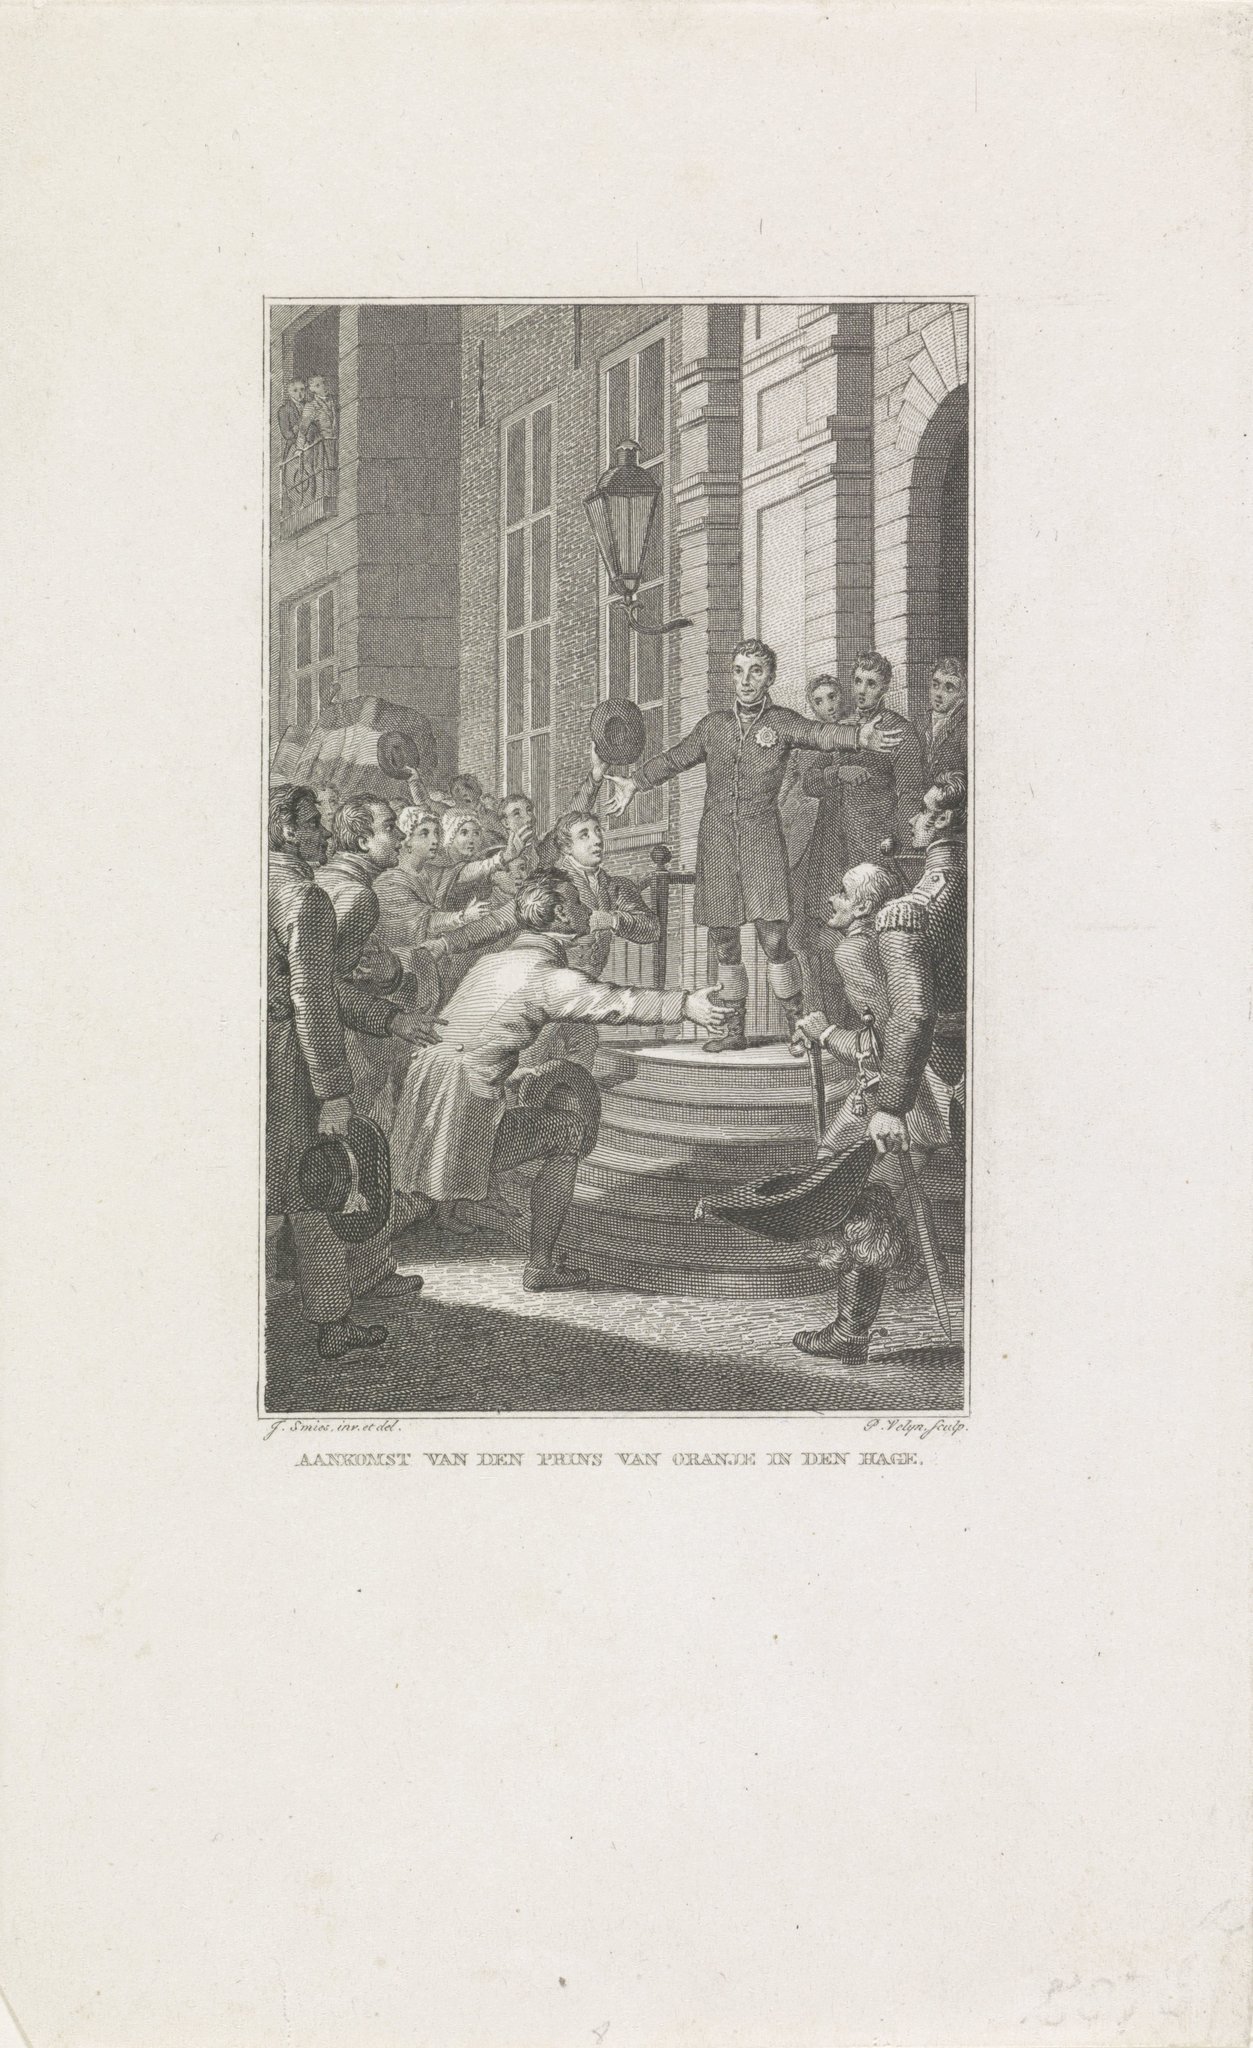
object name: history print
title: Aankomst van den prins van Oranje in Den Hage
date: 1823-1829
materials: paper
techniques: etching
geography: netherlands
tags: the hague, berlin, william i of the netherlands, being welcomed ~ travelling, homage to a ruler, landing of william frederick i (1813)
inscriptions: collector's mark: Lugt 2228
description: Gebruikt als illustratie in: P.G. Witsen Geysbeek en G. Engelberts Gerrits, Schoonheden en merkwaardige tafereelen uit de Nederlandsche geschiedenis. 8 dln, Amsterdam: G. Portielje, 1825-1829.